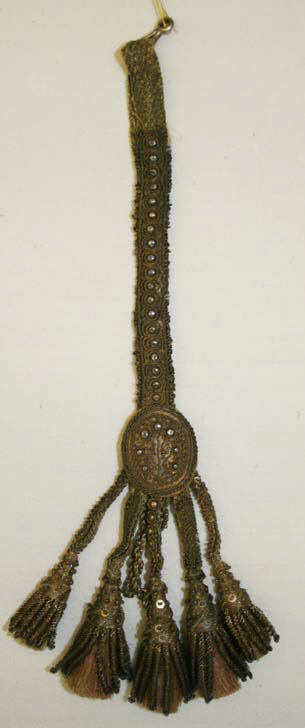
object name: fob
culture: french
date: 1701-1800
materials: metal, silk